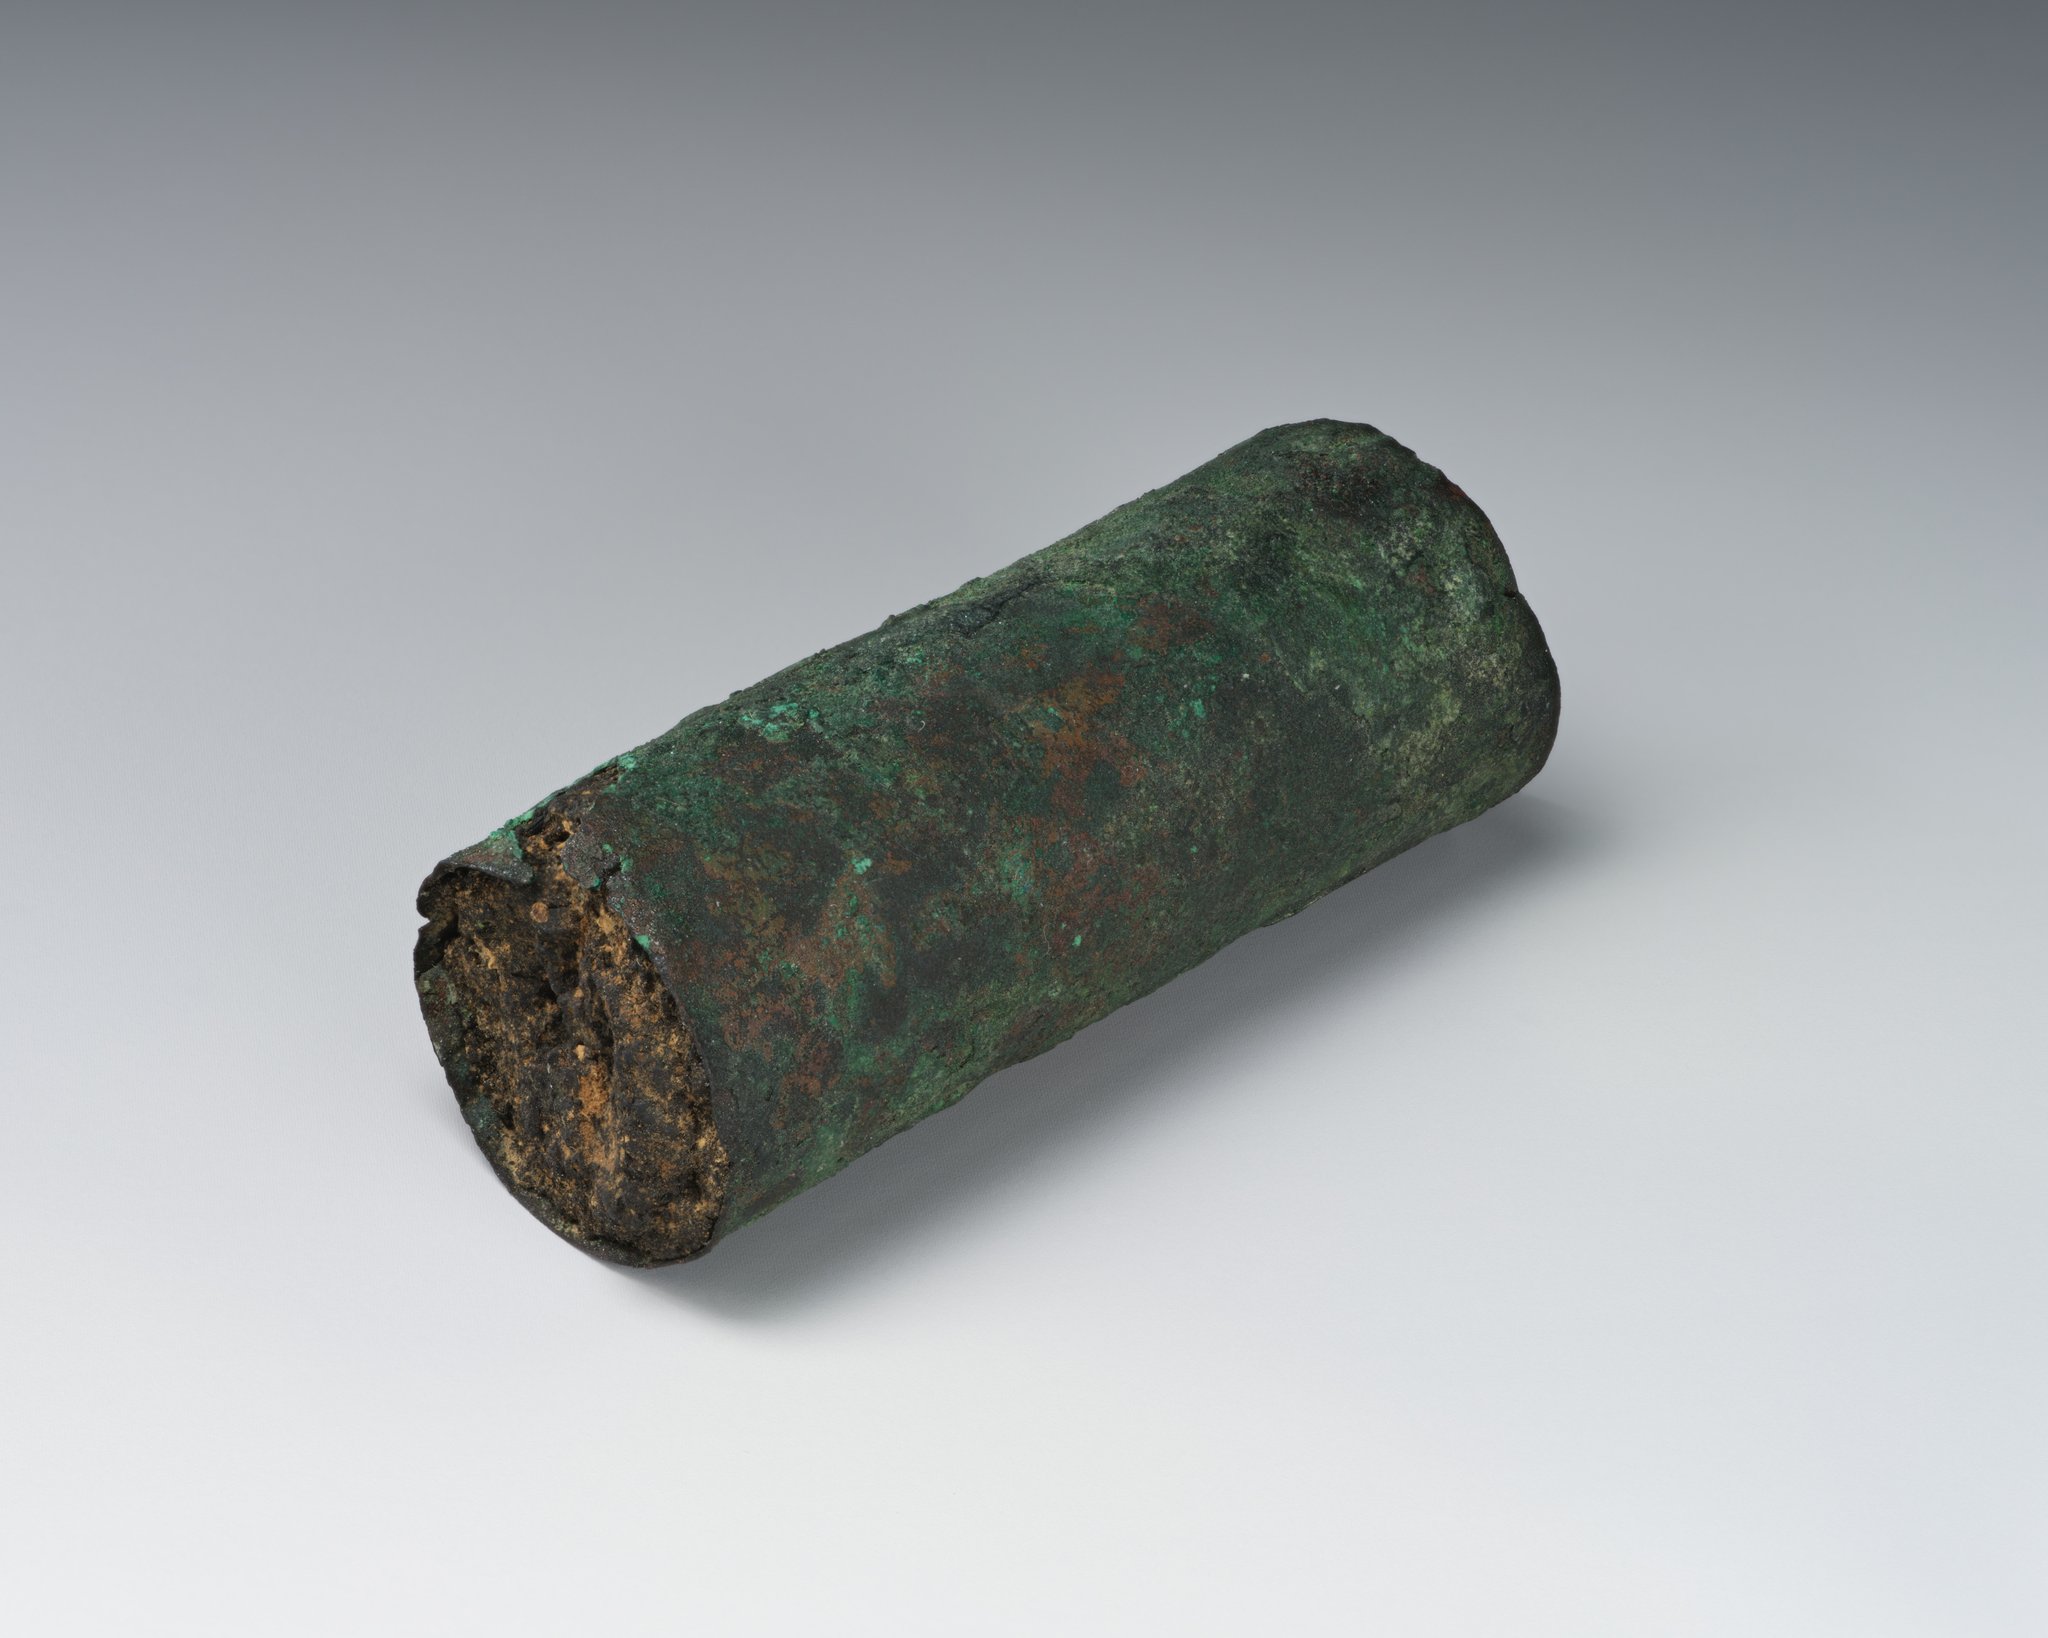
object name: amulet case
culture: sasanian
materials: bronze, copper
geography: mesopotamia